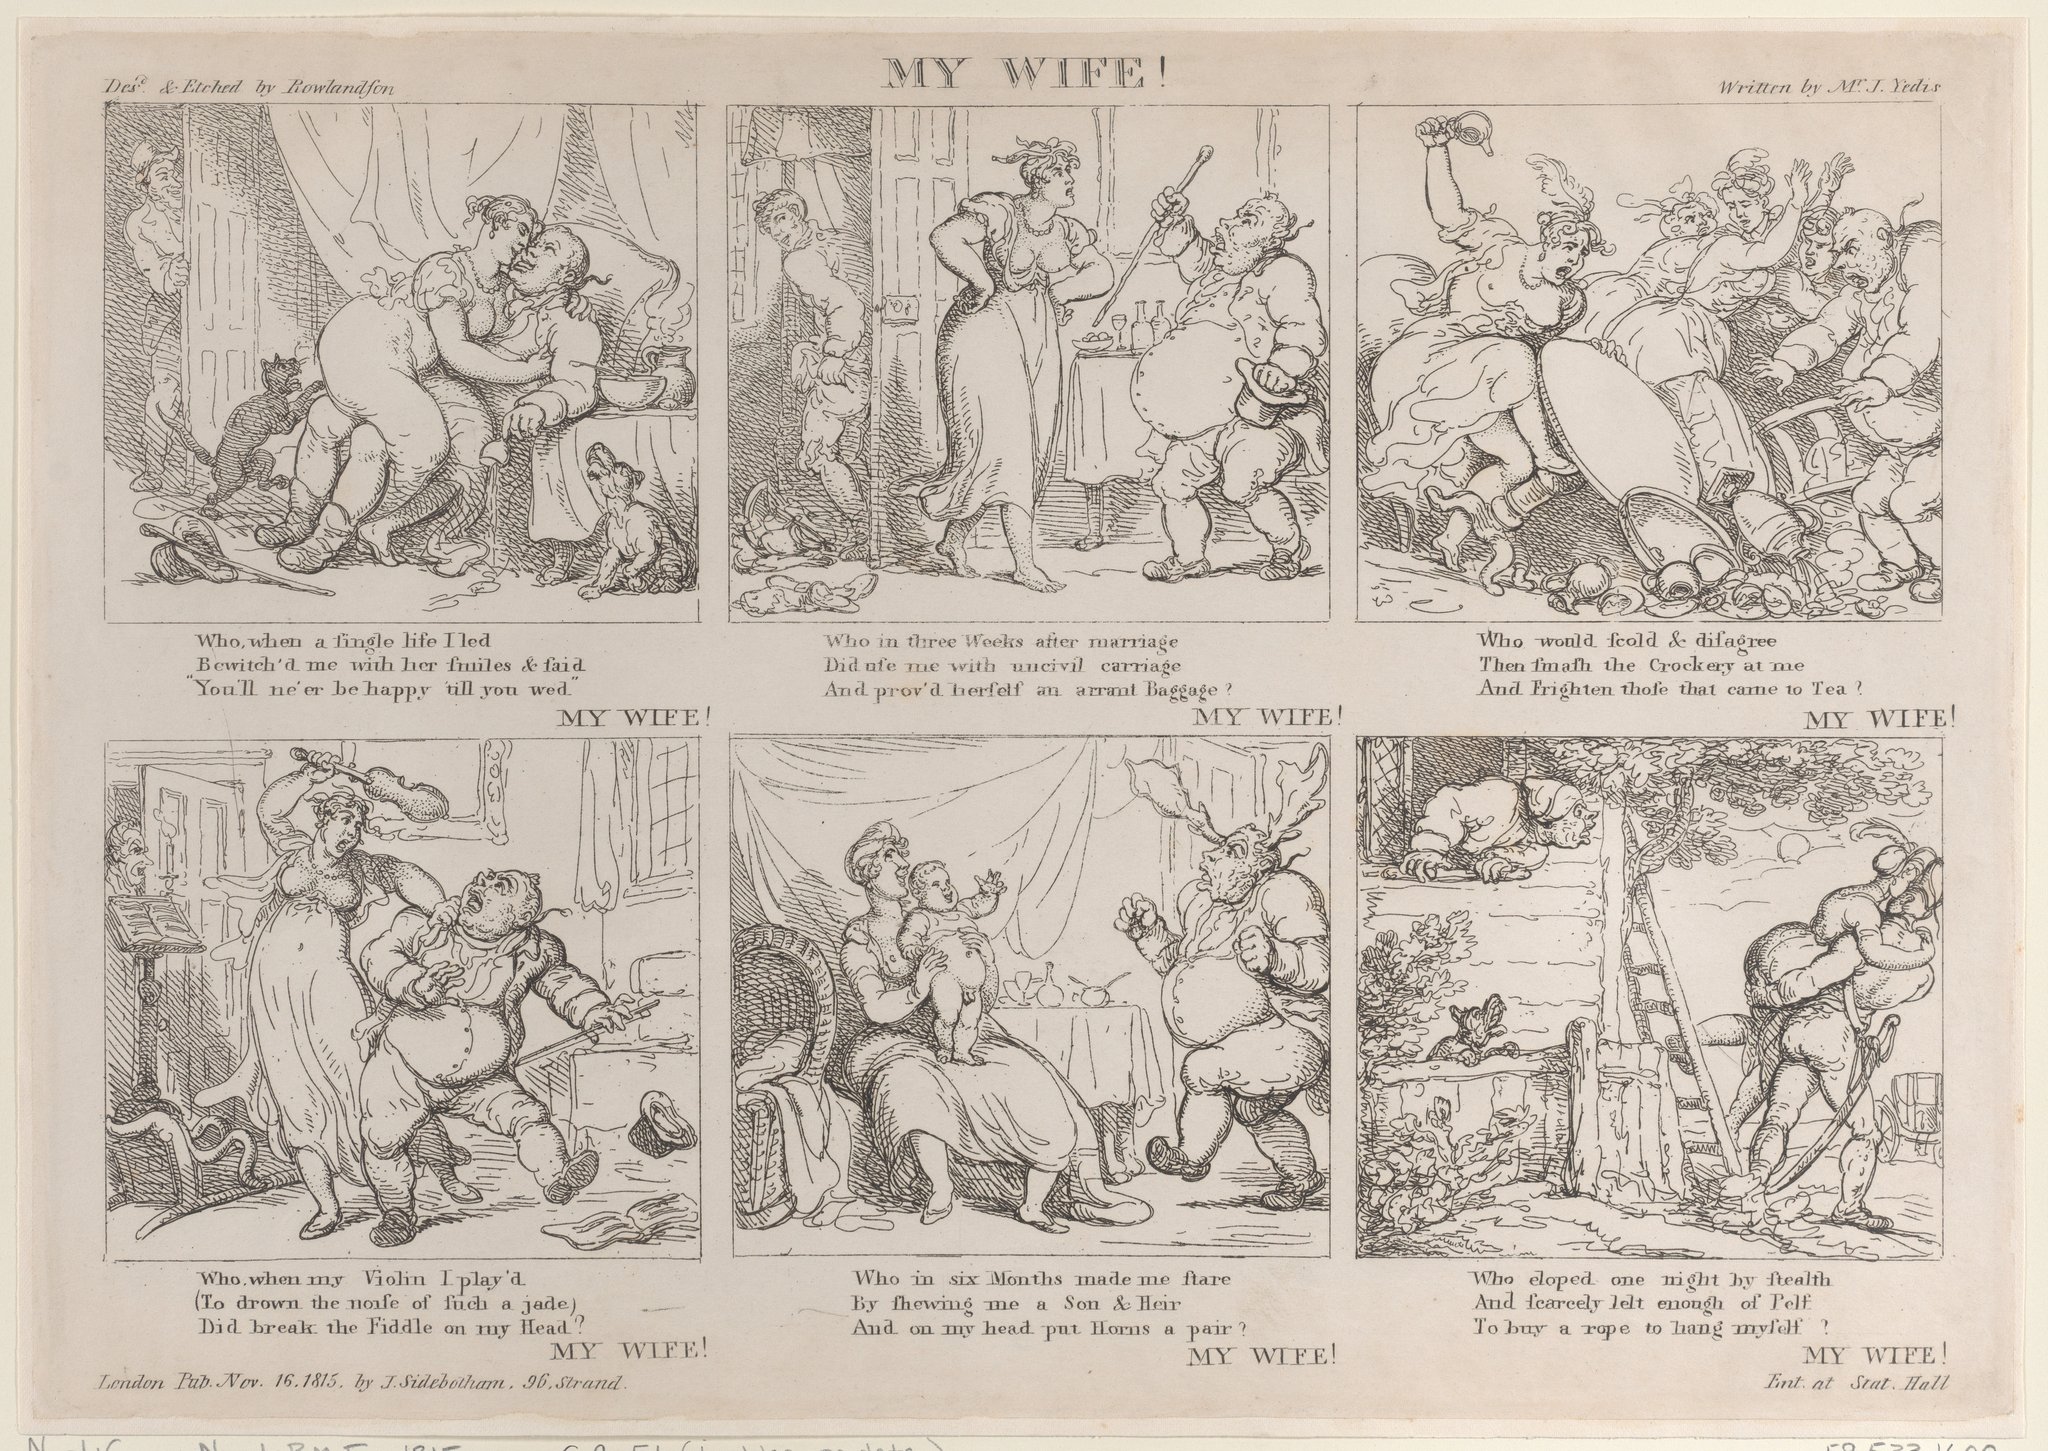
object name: print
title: My Wife!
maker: thomas rowlandson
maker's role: artist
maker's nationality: british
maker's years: 1757-1827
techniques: etching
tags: satire,men,women,dogs